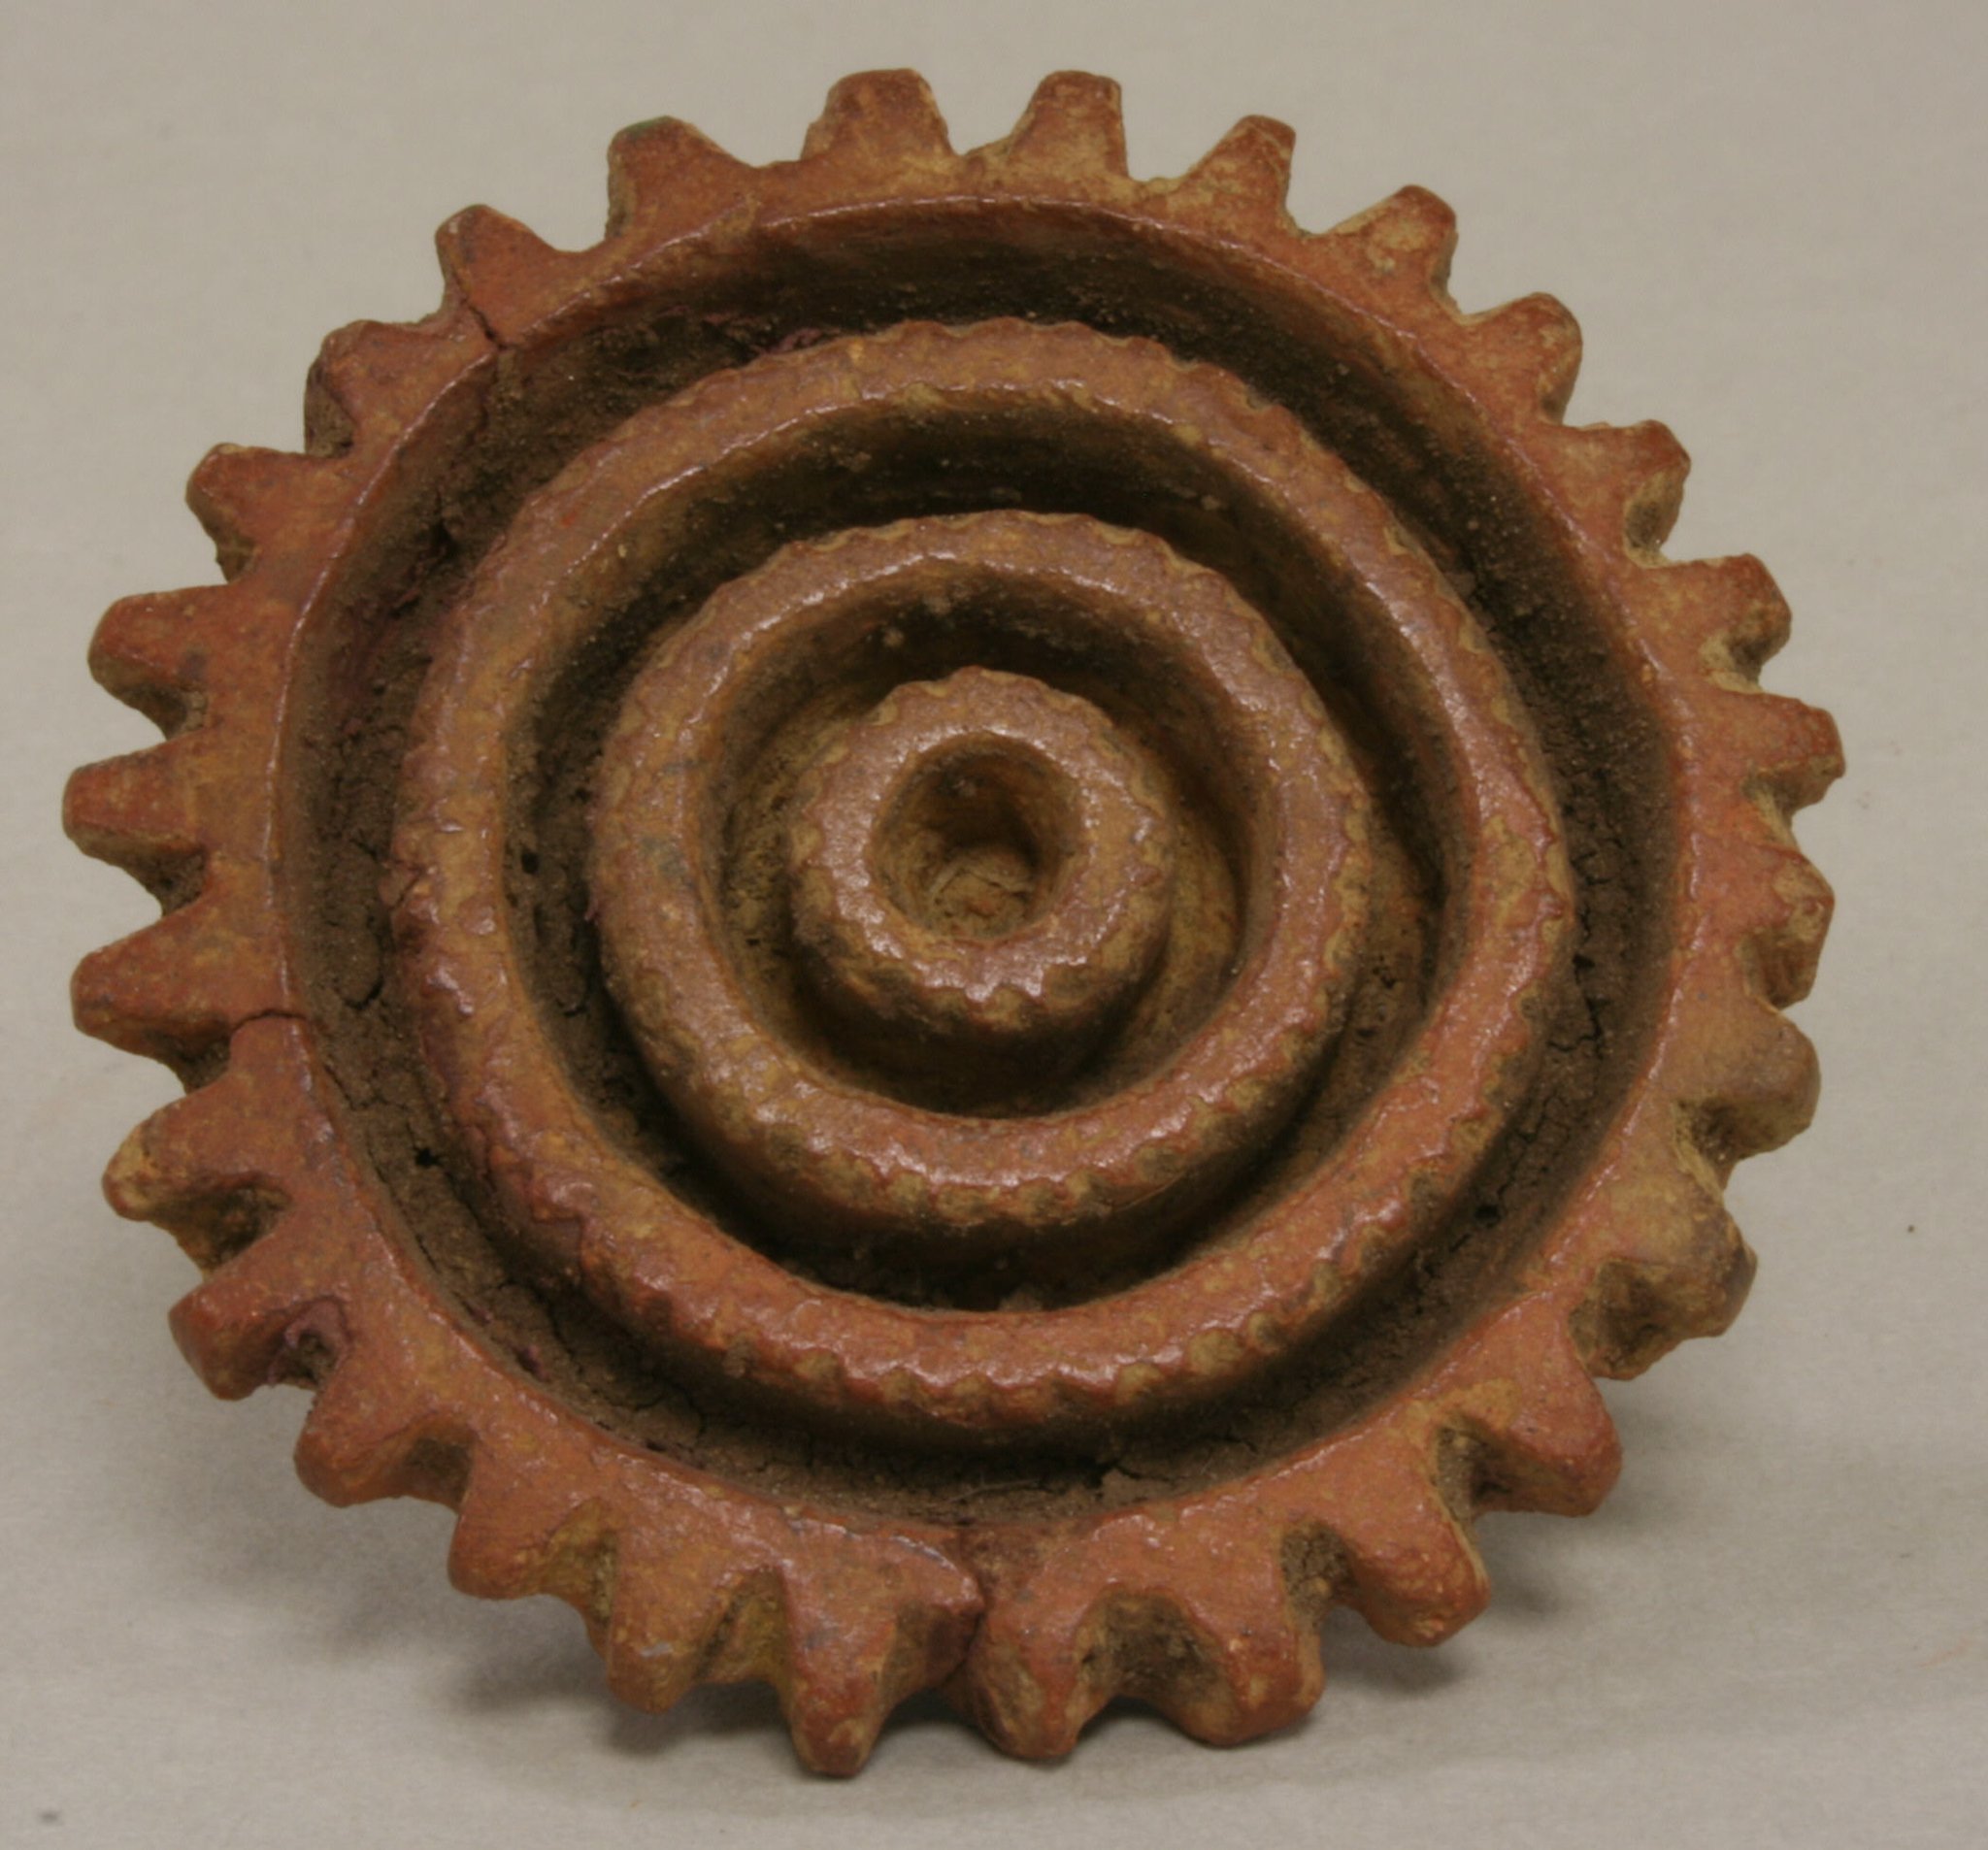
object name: stamp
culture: atlantic watershed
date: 401-600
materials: ceramic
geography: costa rica